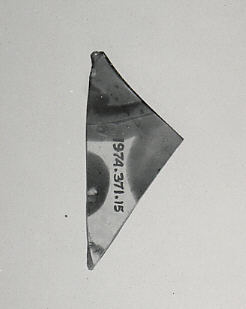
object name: fragment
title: Glass Fragment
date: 801-900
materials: glass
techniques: luster painting, stain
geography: egypt or iraq